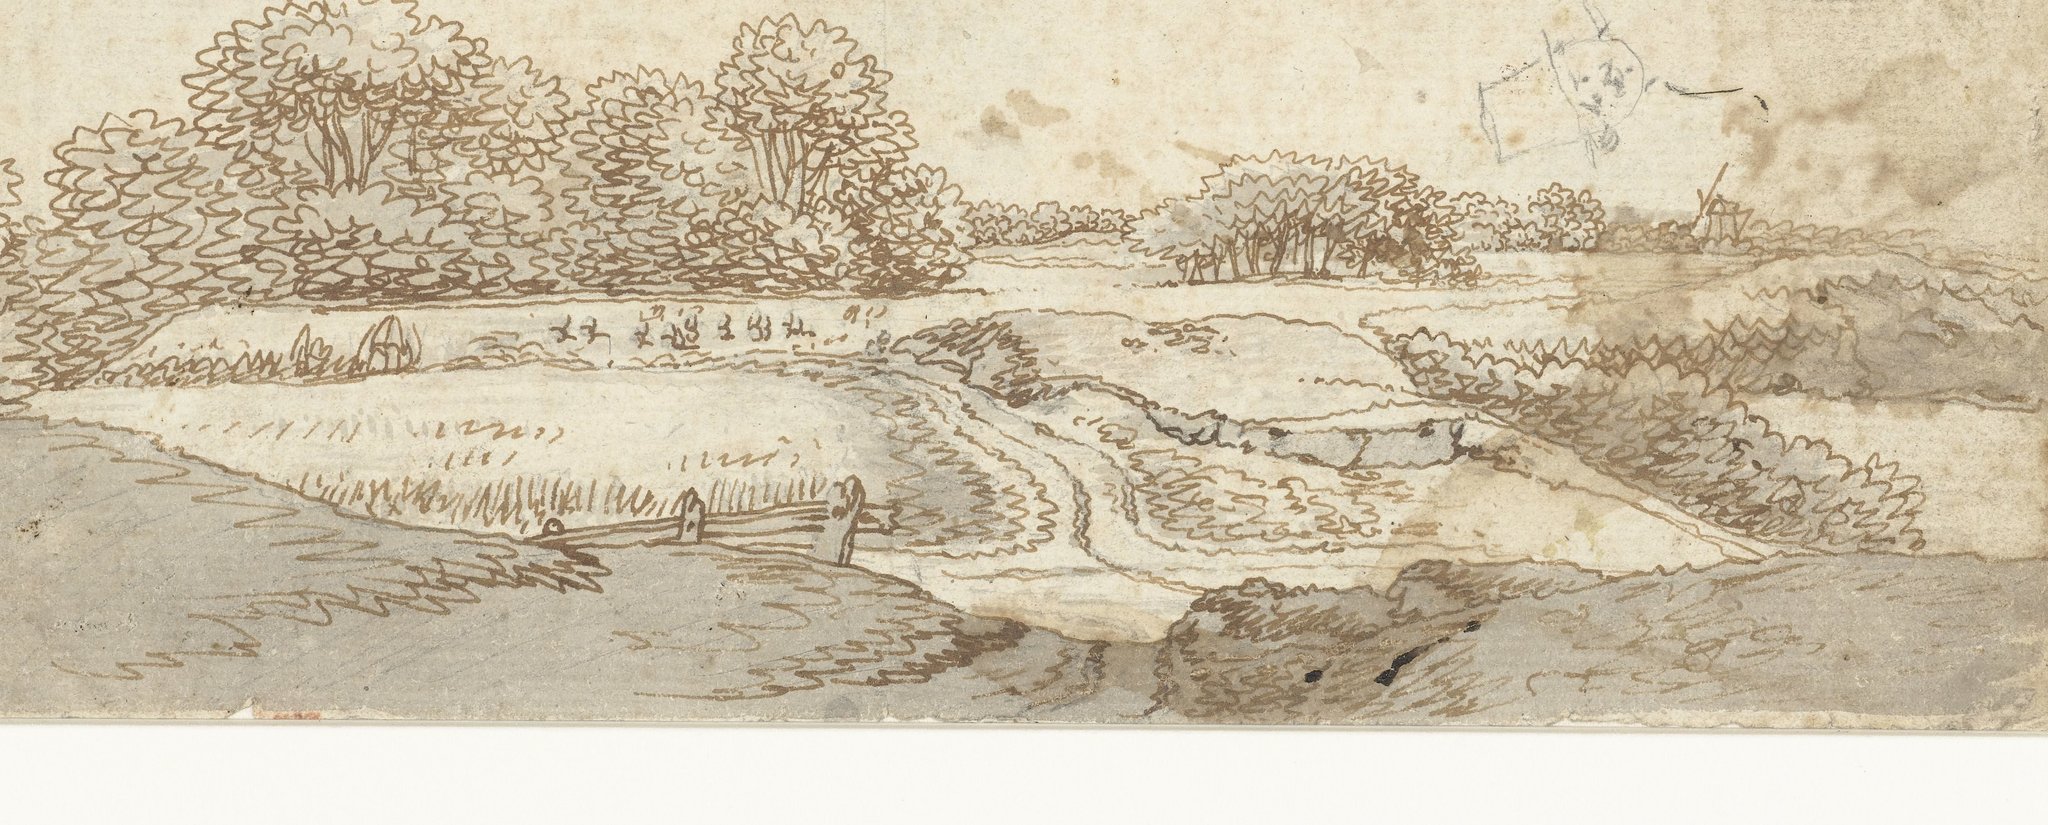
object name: drawing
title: Landschap met weg door velden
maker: Anonymous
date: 1700-1800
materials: ink, paper, pencil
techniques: brush, pen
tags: road, path, windmill in landscape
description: Landschap met weg door velden; in de verte staat een molen.